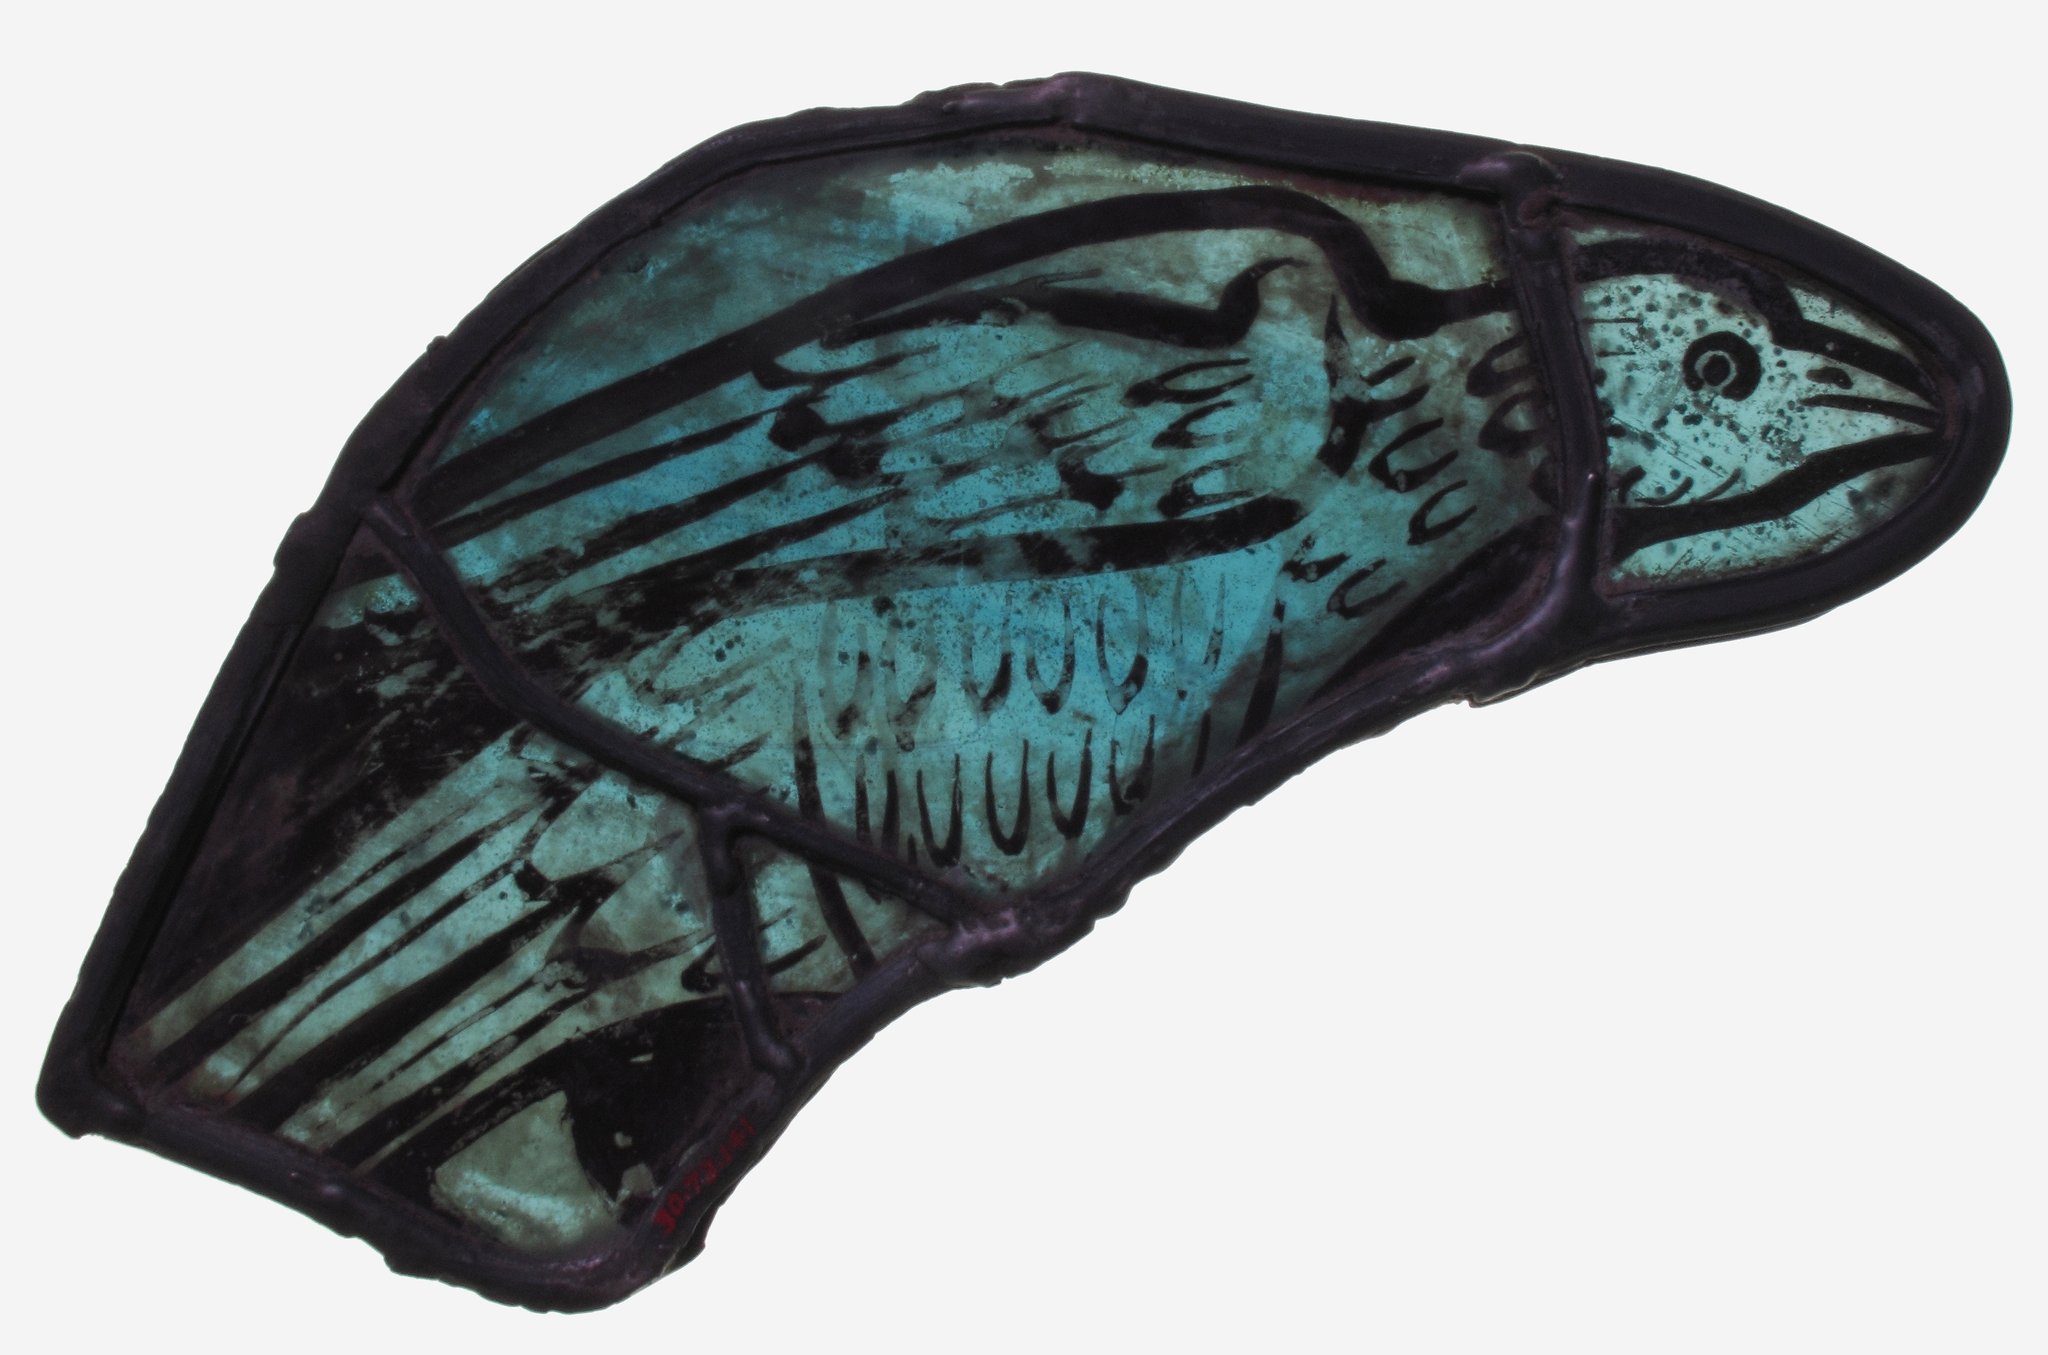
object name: fragment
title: Glass Fragment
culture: french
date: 1201-1400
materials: glass, metal